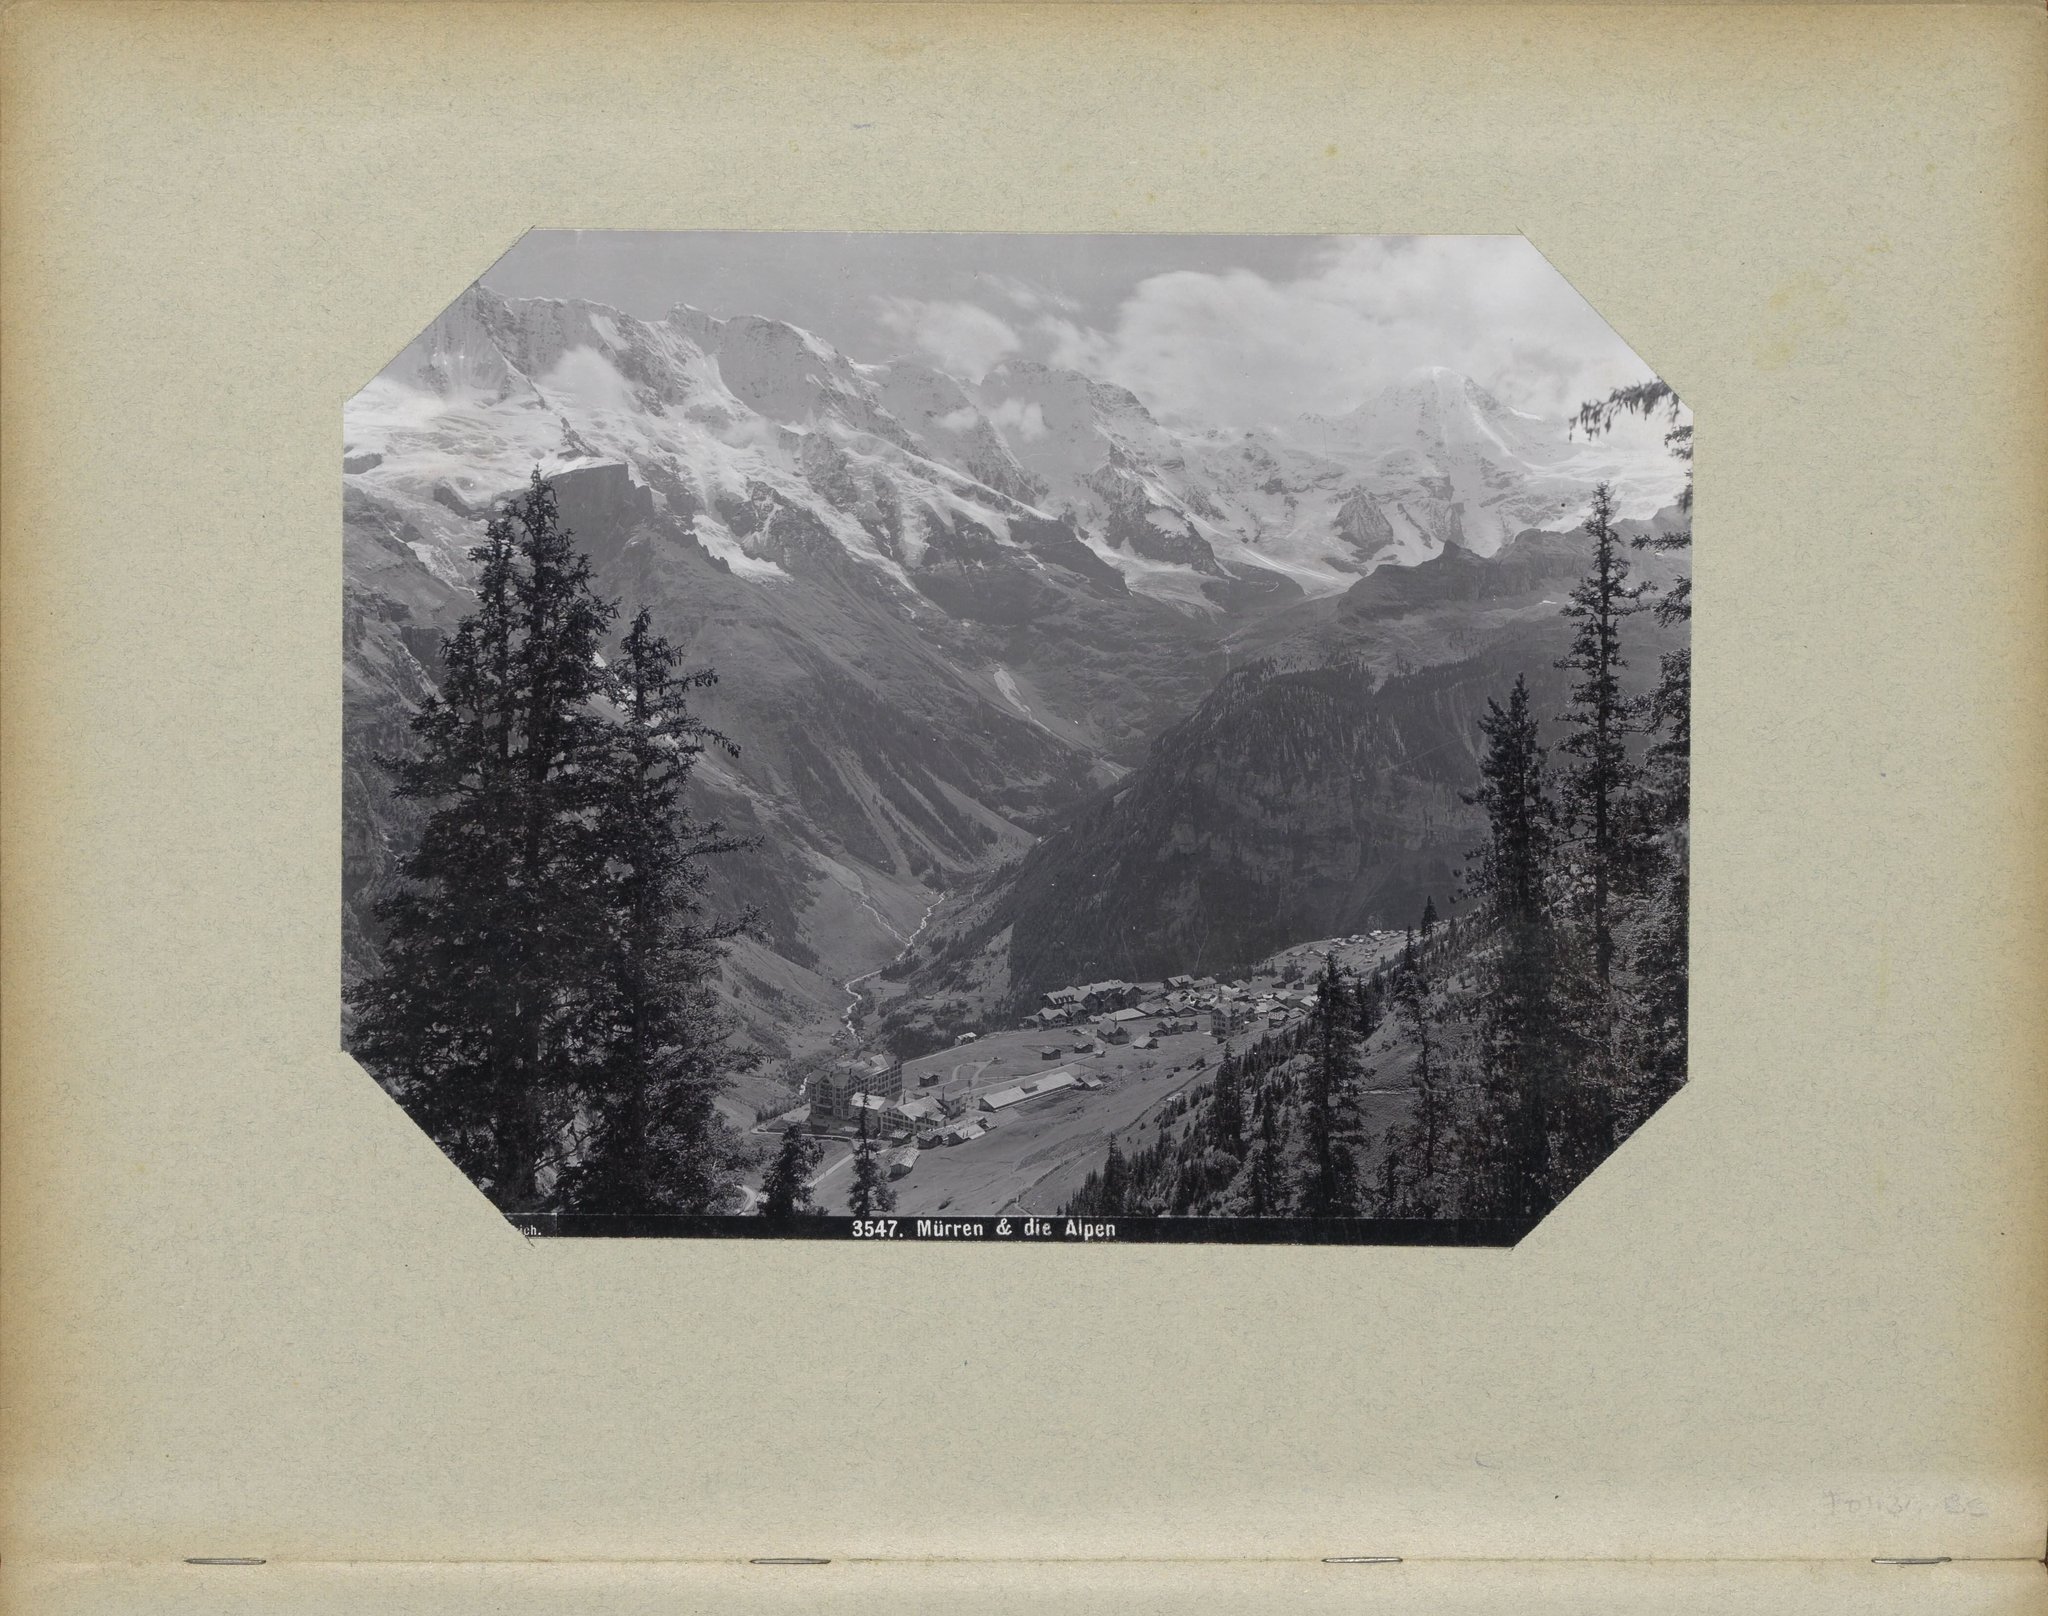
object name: photograph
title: Gezicht op Mürren en de omliggende Alpentoppen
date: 1880-1910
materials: paper, photographic support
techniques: collodion silver print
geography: mürren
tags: prospect of village, silhouette of village, mountain-range, snow peaks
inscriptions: negative number: ‘3547’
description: Onderdeel van Reisalbum met bezienswaardigheden in Engeland, Zwitserland, Frankrijk en Duitsland.